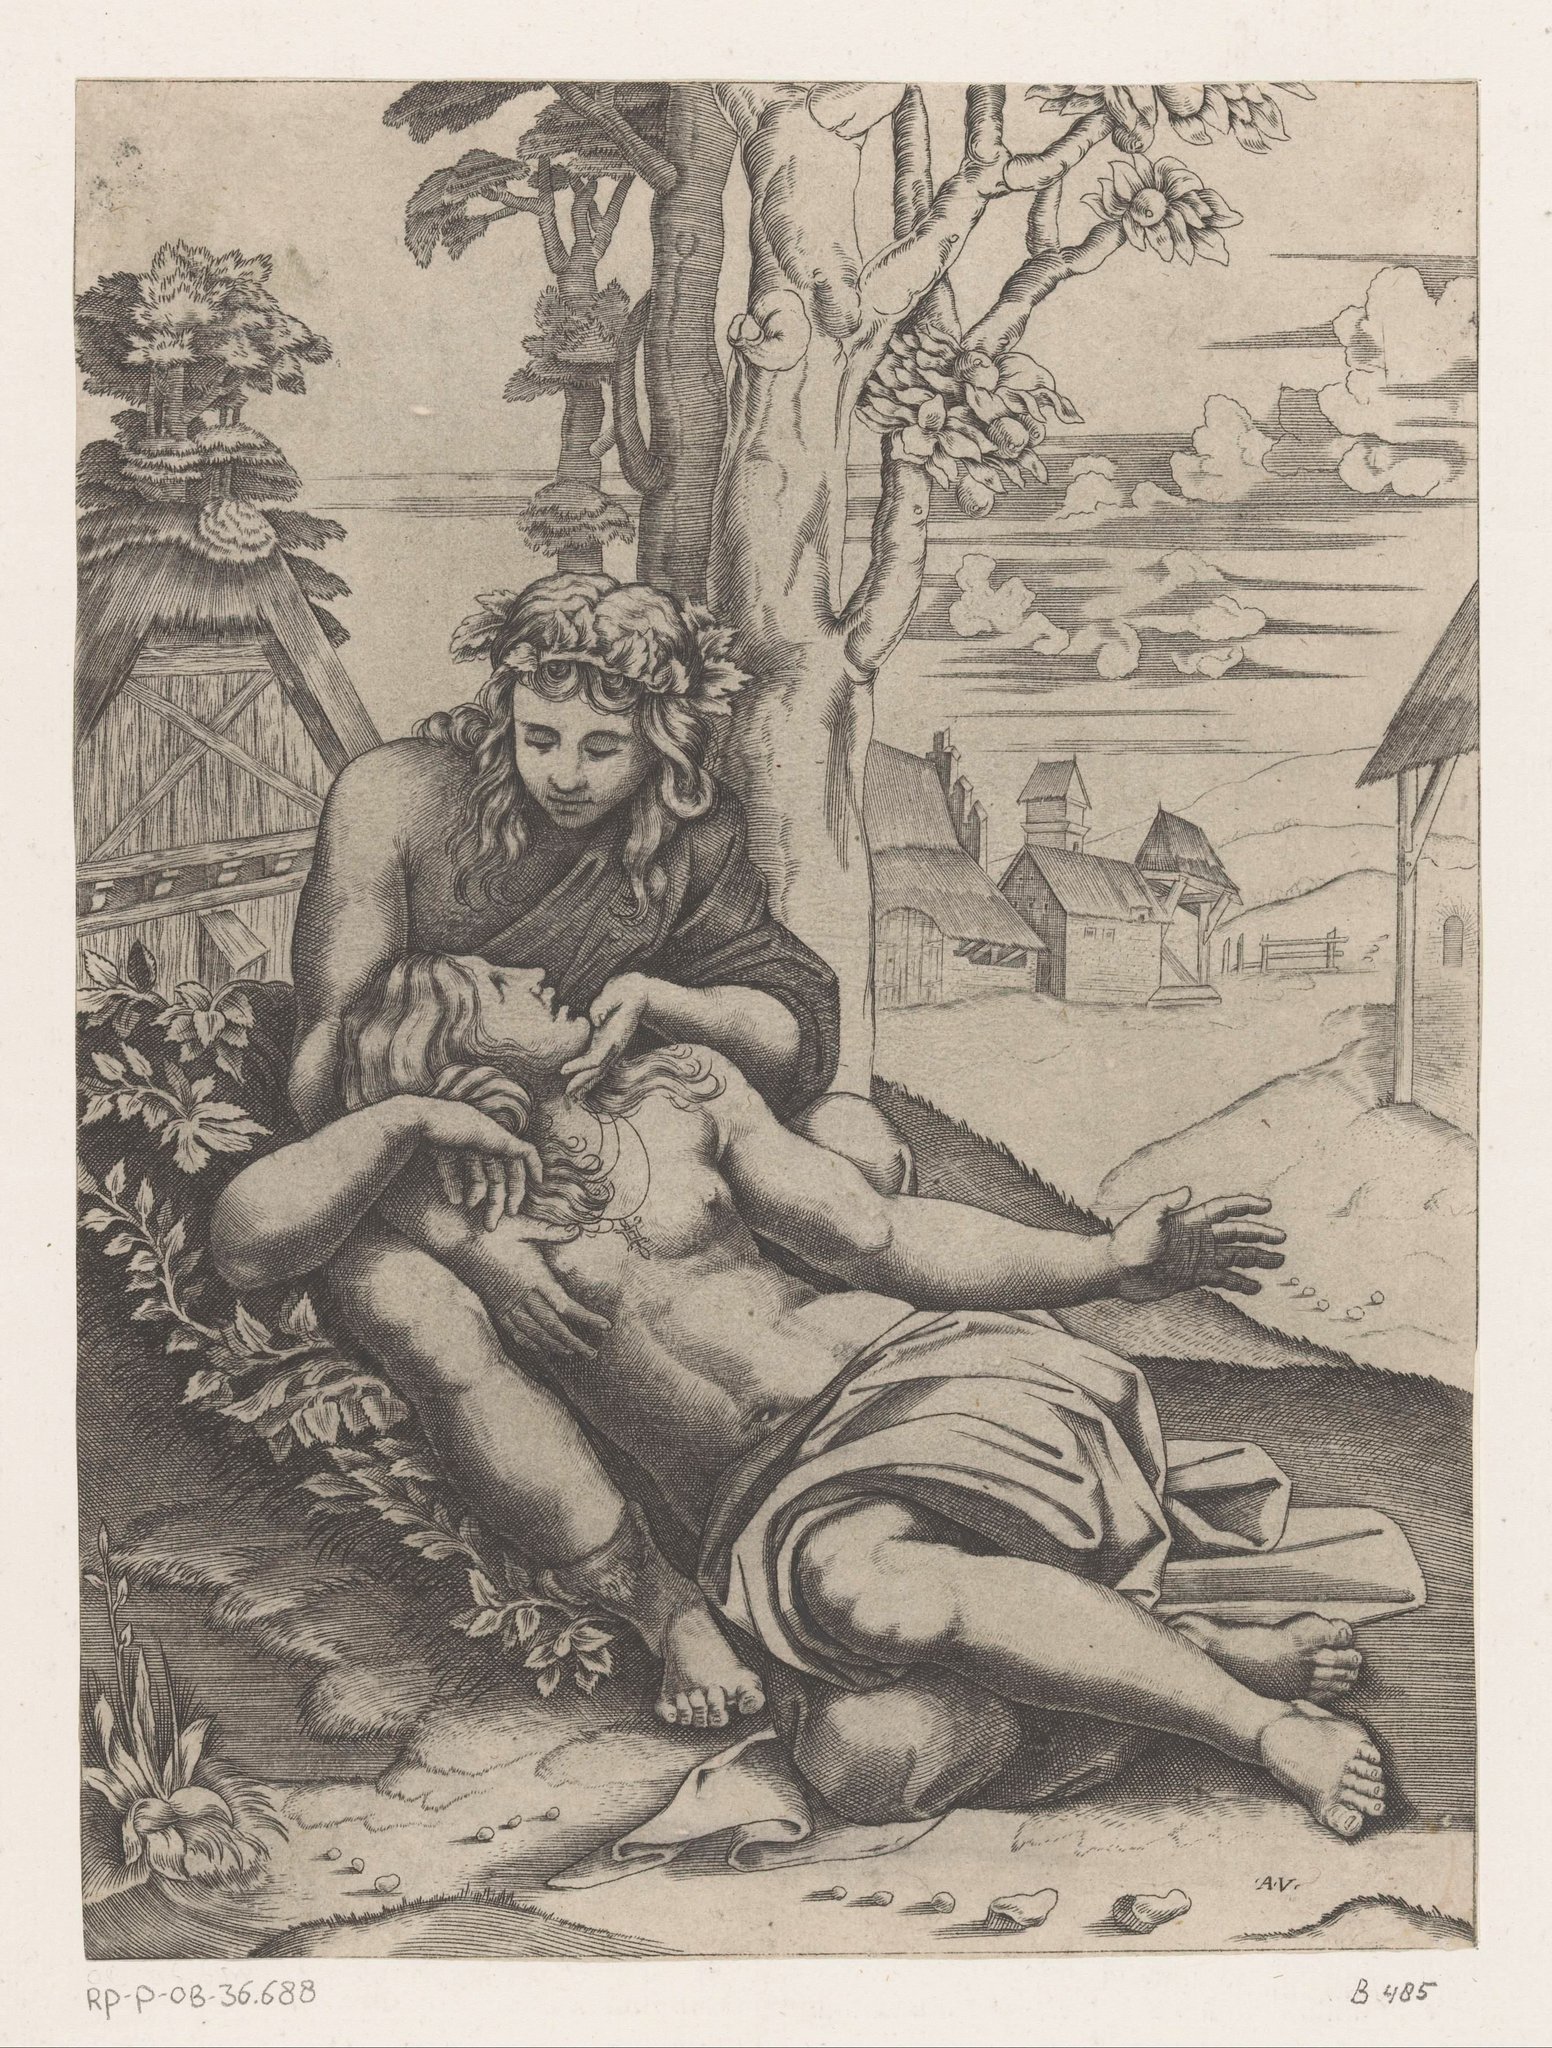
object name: print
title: Venus en Adonis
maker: agostino veneziano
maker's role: draughtsman, painter, print maker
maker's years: 1490-1536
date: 1500-1536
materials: paper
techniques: engraving, etching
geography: italy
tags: medoro, angelica, venus and adonis as lovers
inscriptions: collector's mark: Lugt 240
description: Prent naar een getekende voorstudie door Giulio Romano voor een voorstelling van Venus en Adonis op een fresco op de noordwand van de Stufetta del Bibbiena in het Vaticaan. De voorstudie door Romano bevindt zich in de Albertina te Wenen (inv.nr. 17632). Dezelfde figuren van Venus en Adonis komen voor op een prent van Marcantonio Raimondi. Waarschijnlijk is de ene prent niet naar de andere gekopiëerd, maar hebben beide prentmakers zich afzonderlijk van elkaar direct gebaseerd op Romano's tekening. De boom die Veneziano voor de achtergrond gebruikte is afkomstig uit een prent van Albrecht Dürer (Bartsch 131); het huis is overgenomen van een prent van Lucas van Leyden (Bartsch 126).